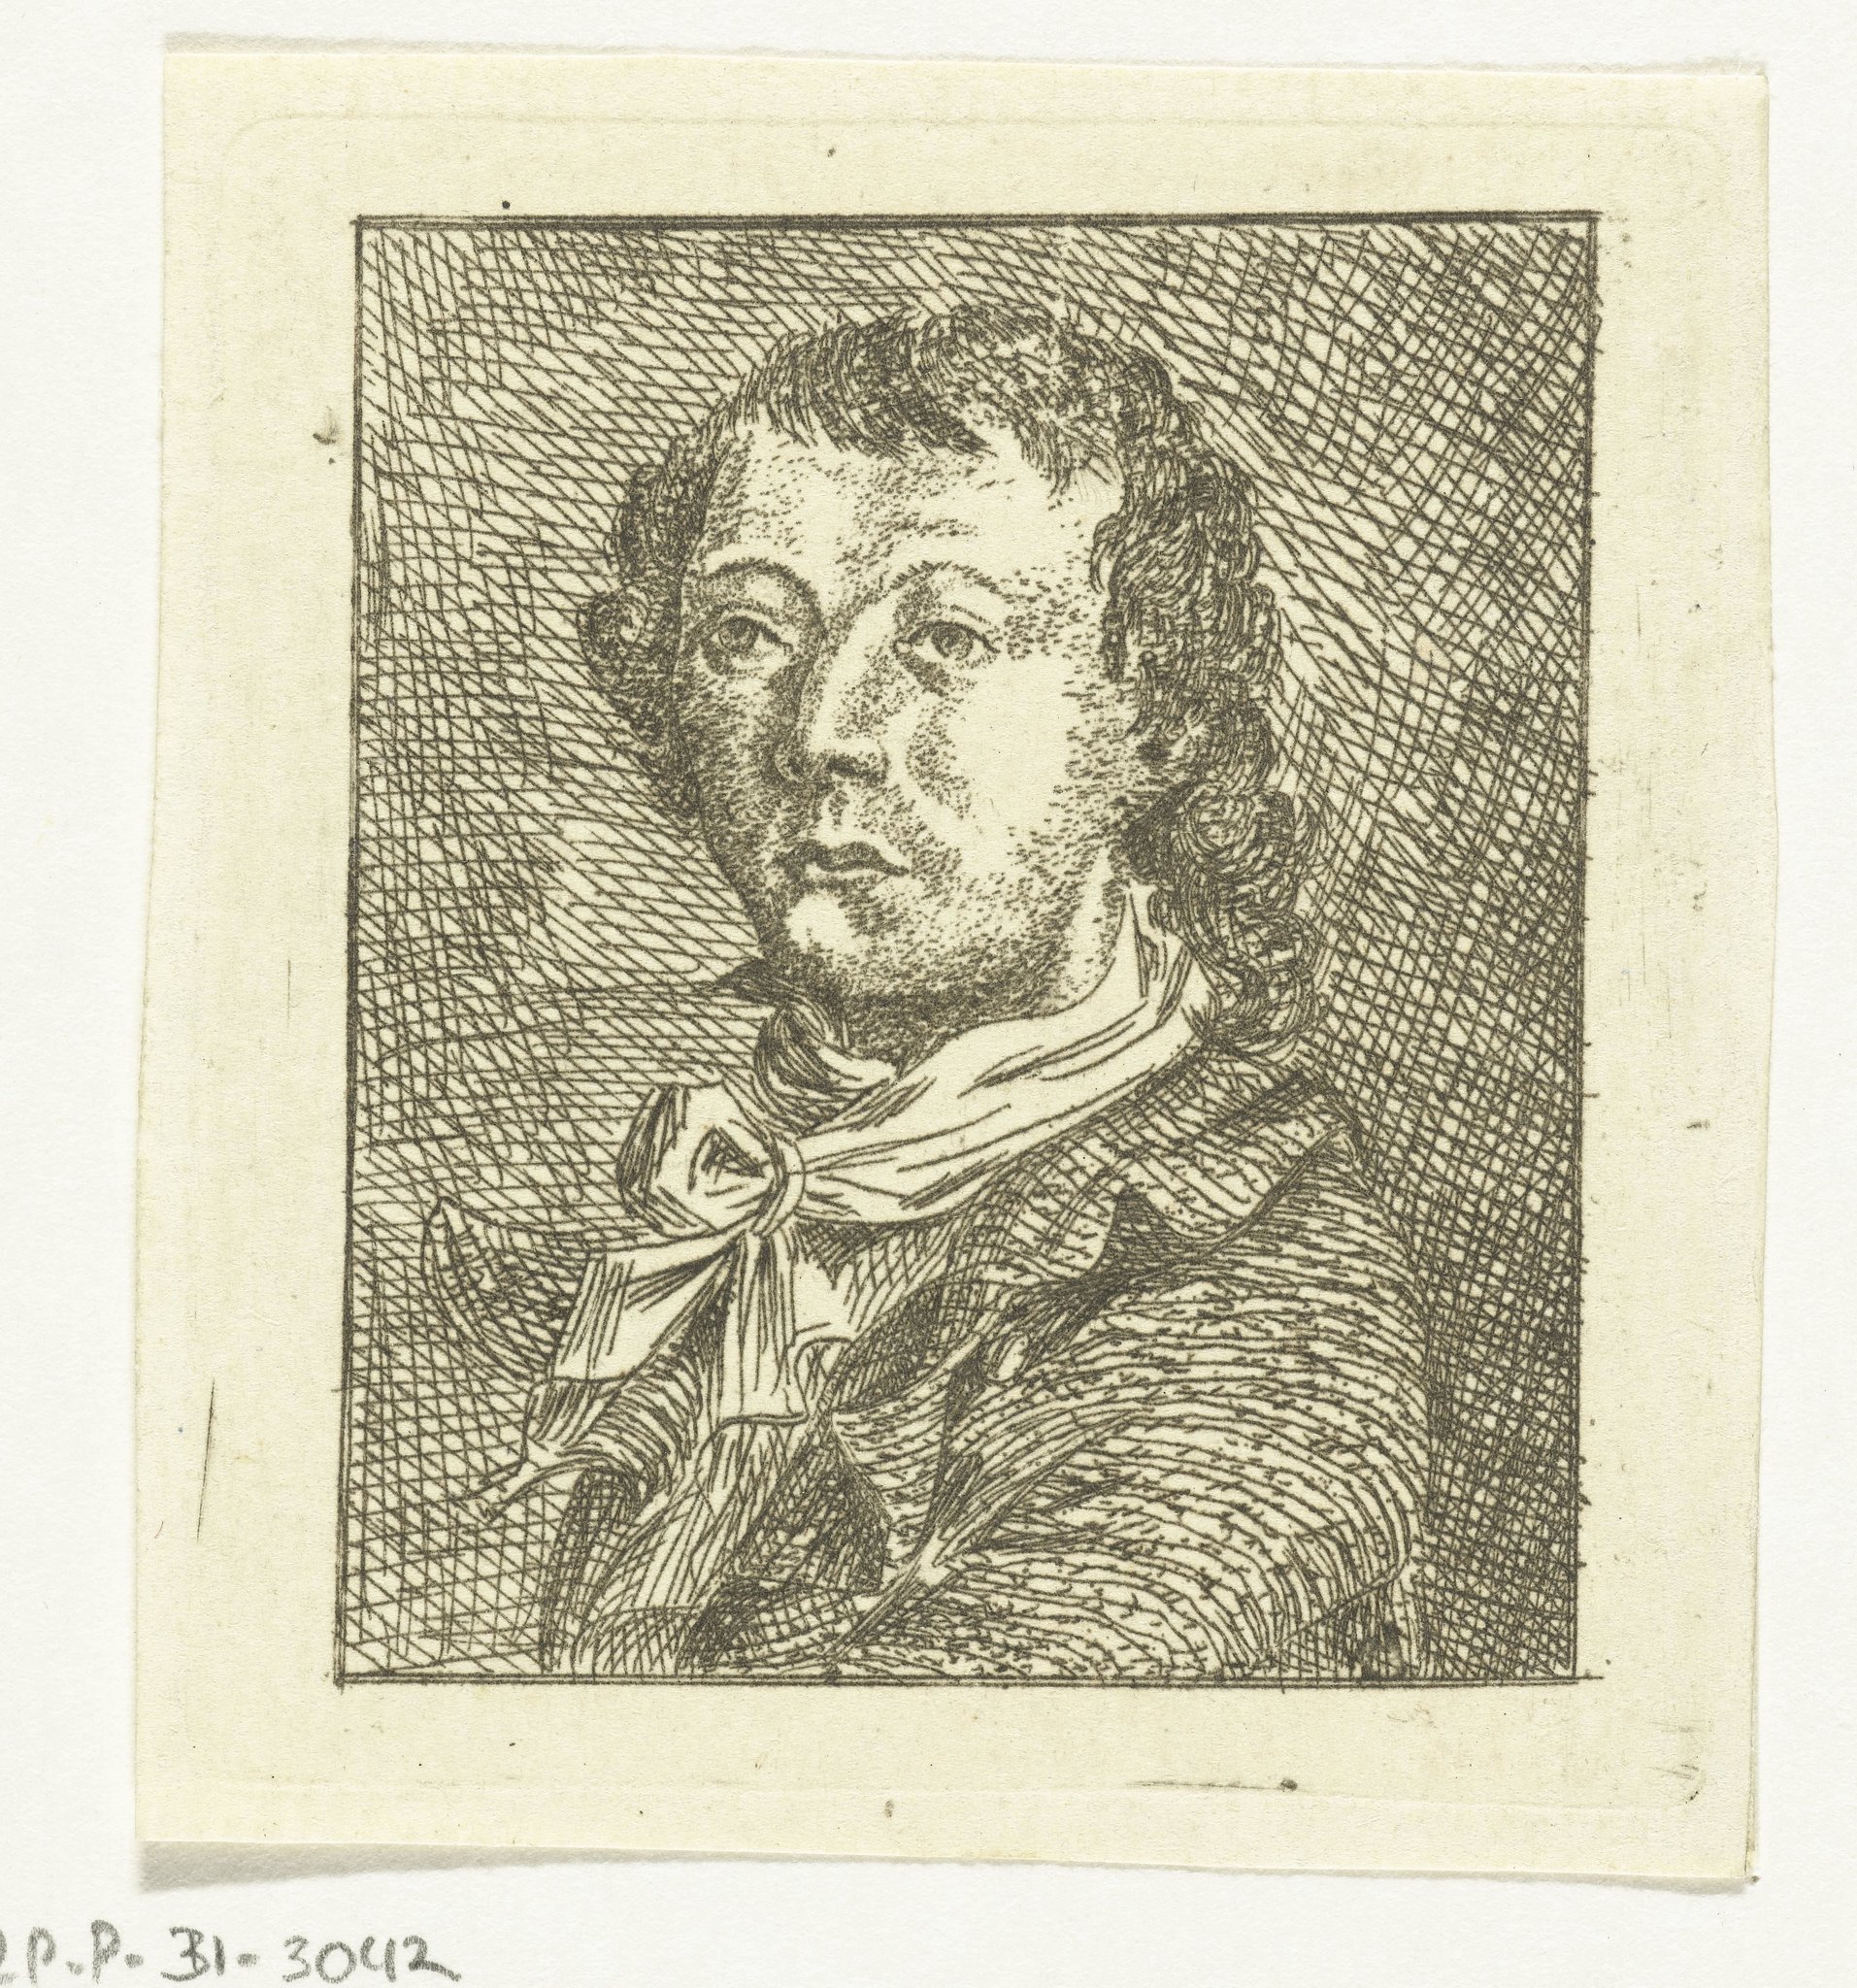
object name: print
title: Portretbuste van een jonge man met witte das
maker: anthonie van den bos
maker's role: draughtsman, print maker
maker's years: 1763-1838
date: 1778-1838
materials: paper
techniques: etching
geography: netherlands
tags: anonymous historical person portrayed alone (+ three-quarter view portrait)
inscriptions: collector's mark: Lugt 2228